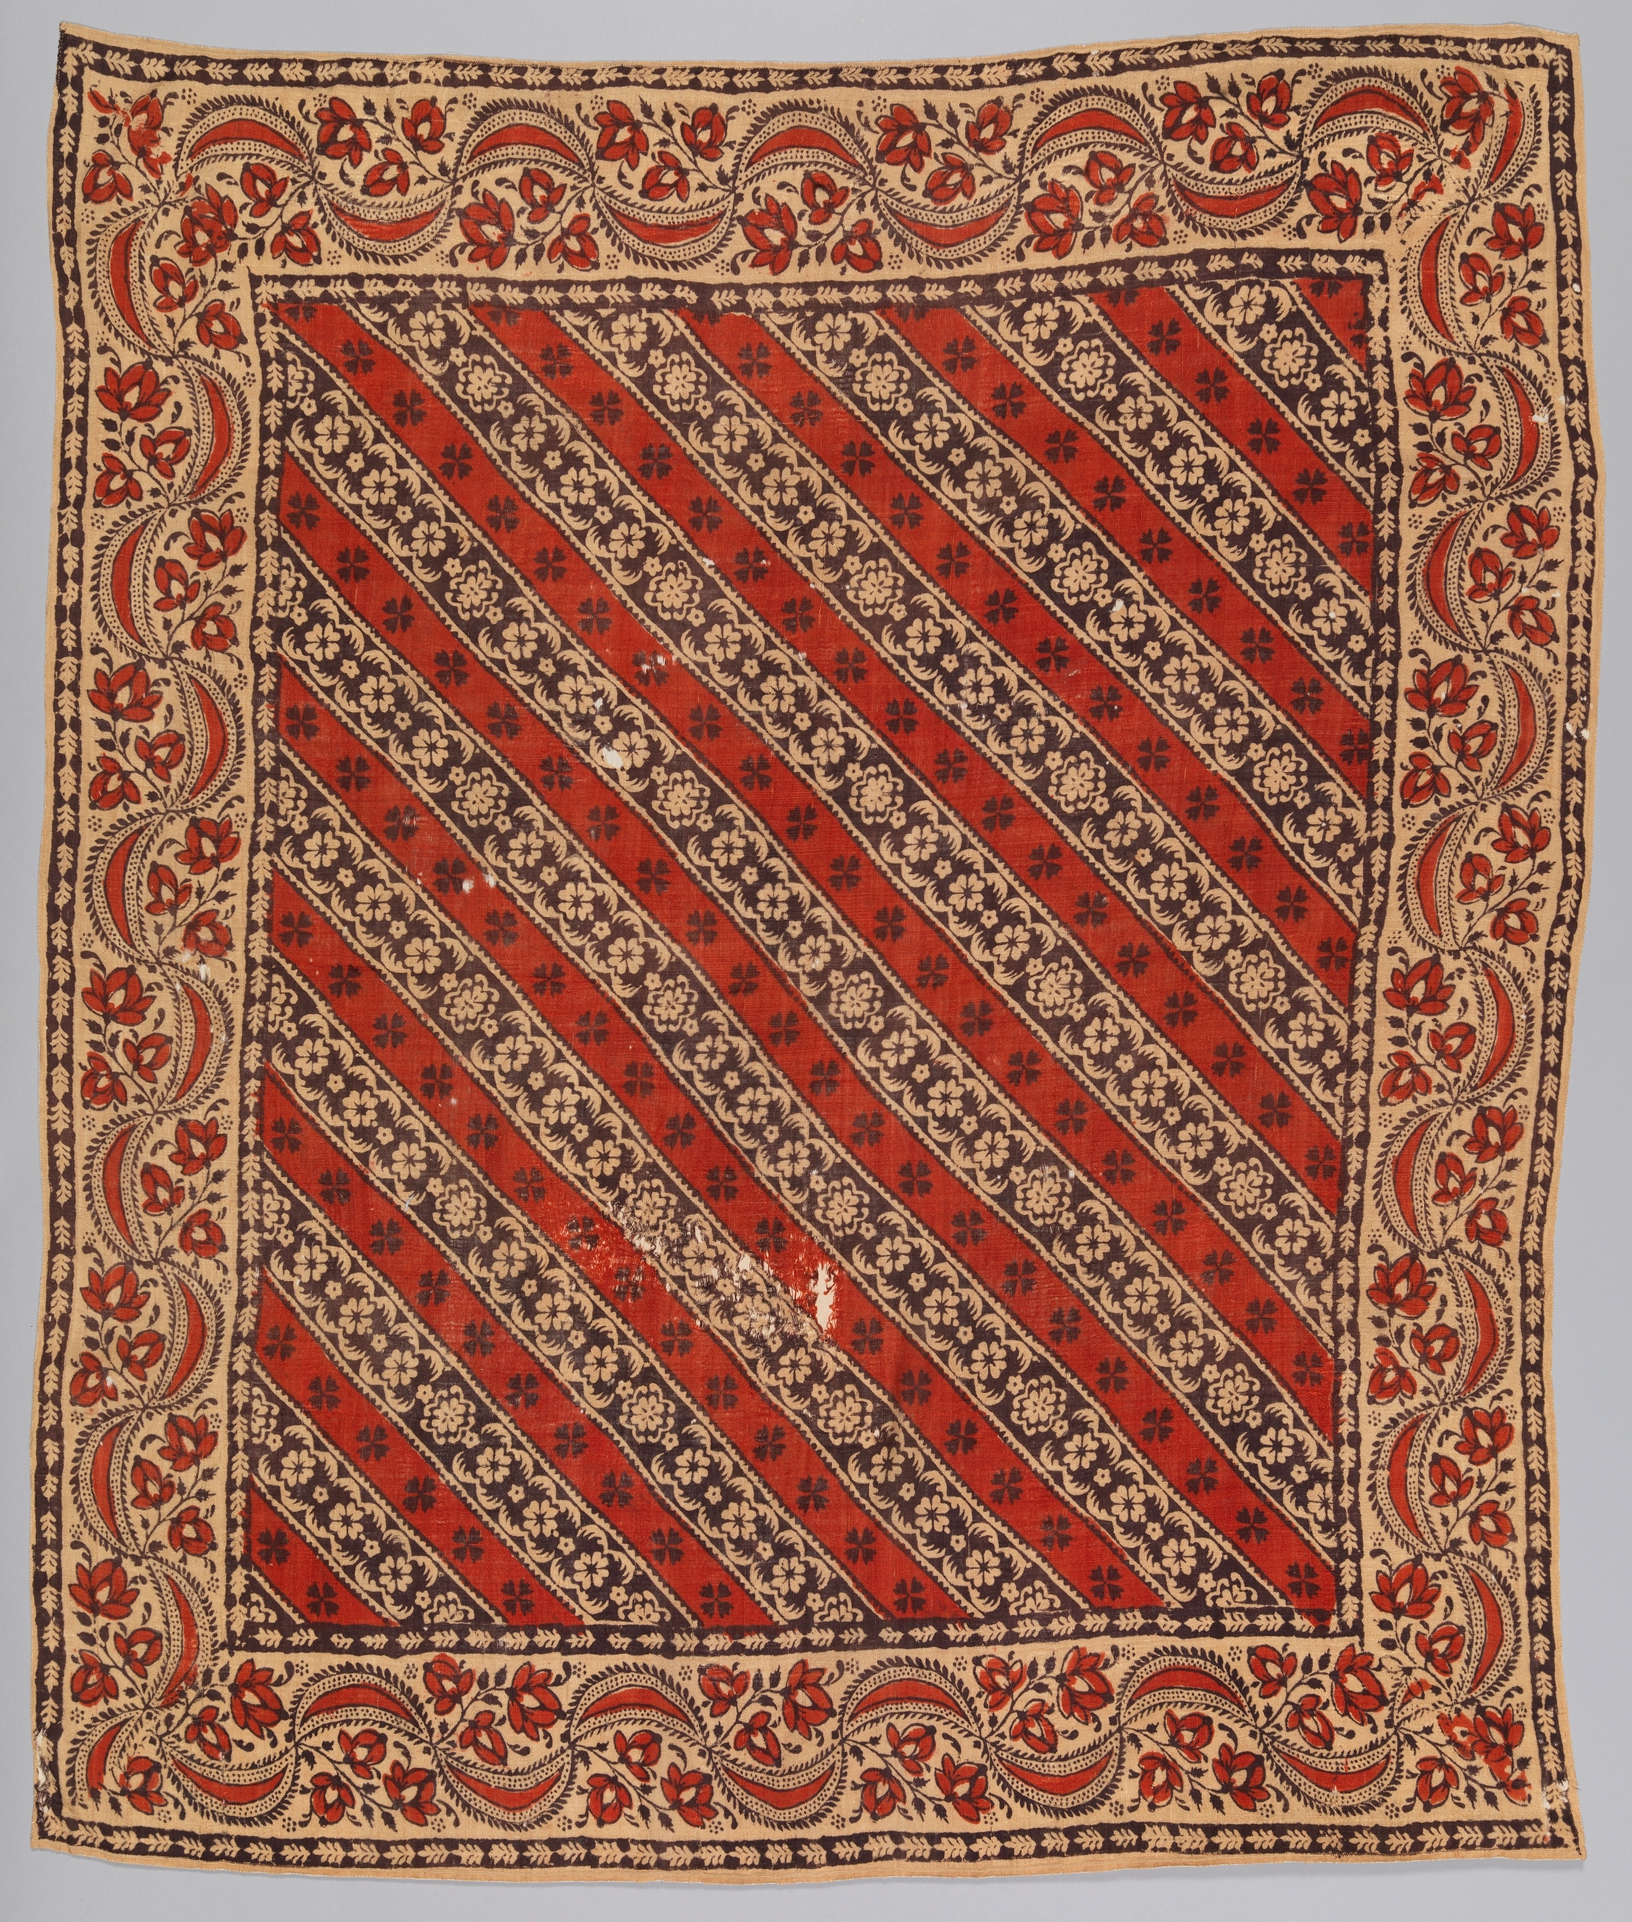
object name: handkerchief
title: Man's handkerchief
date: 1801-1900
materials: silk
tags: flowers